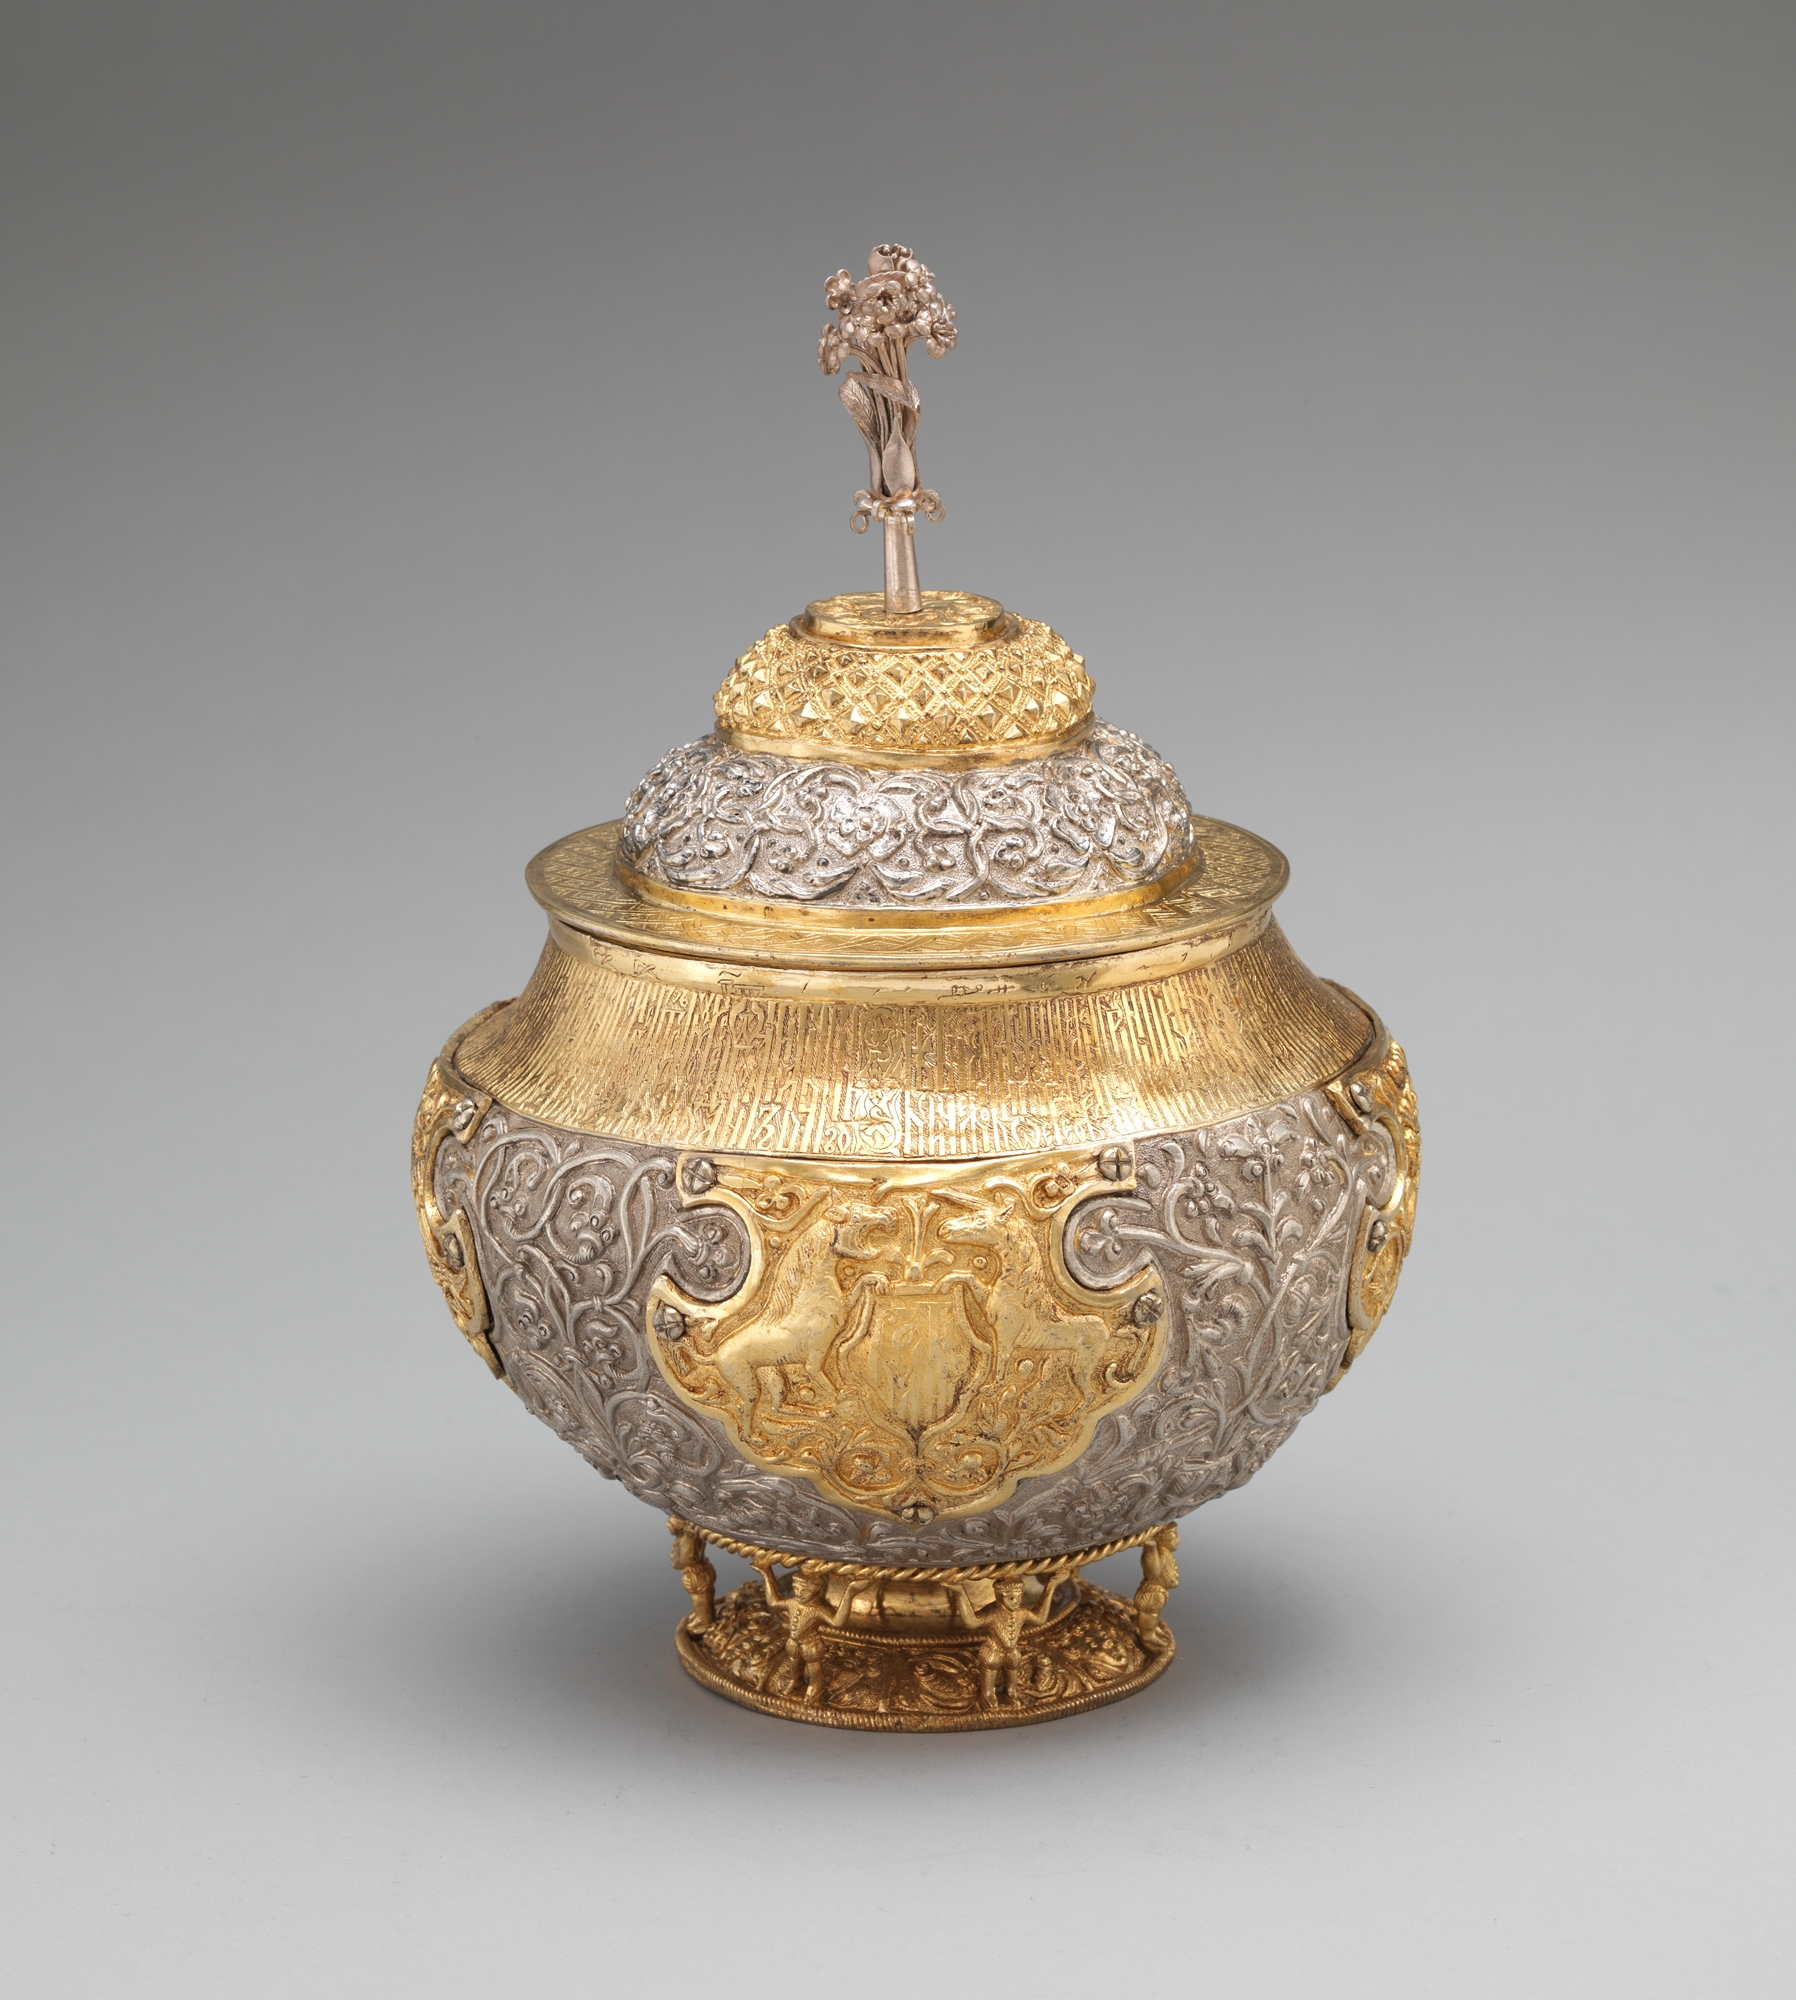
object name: bratina with cover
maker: elkington & co.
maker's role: manufacturer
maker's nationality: british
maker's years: 1829-1963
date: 1801-1900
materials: metal, silver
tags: flowers,coat of arms